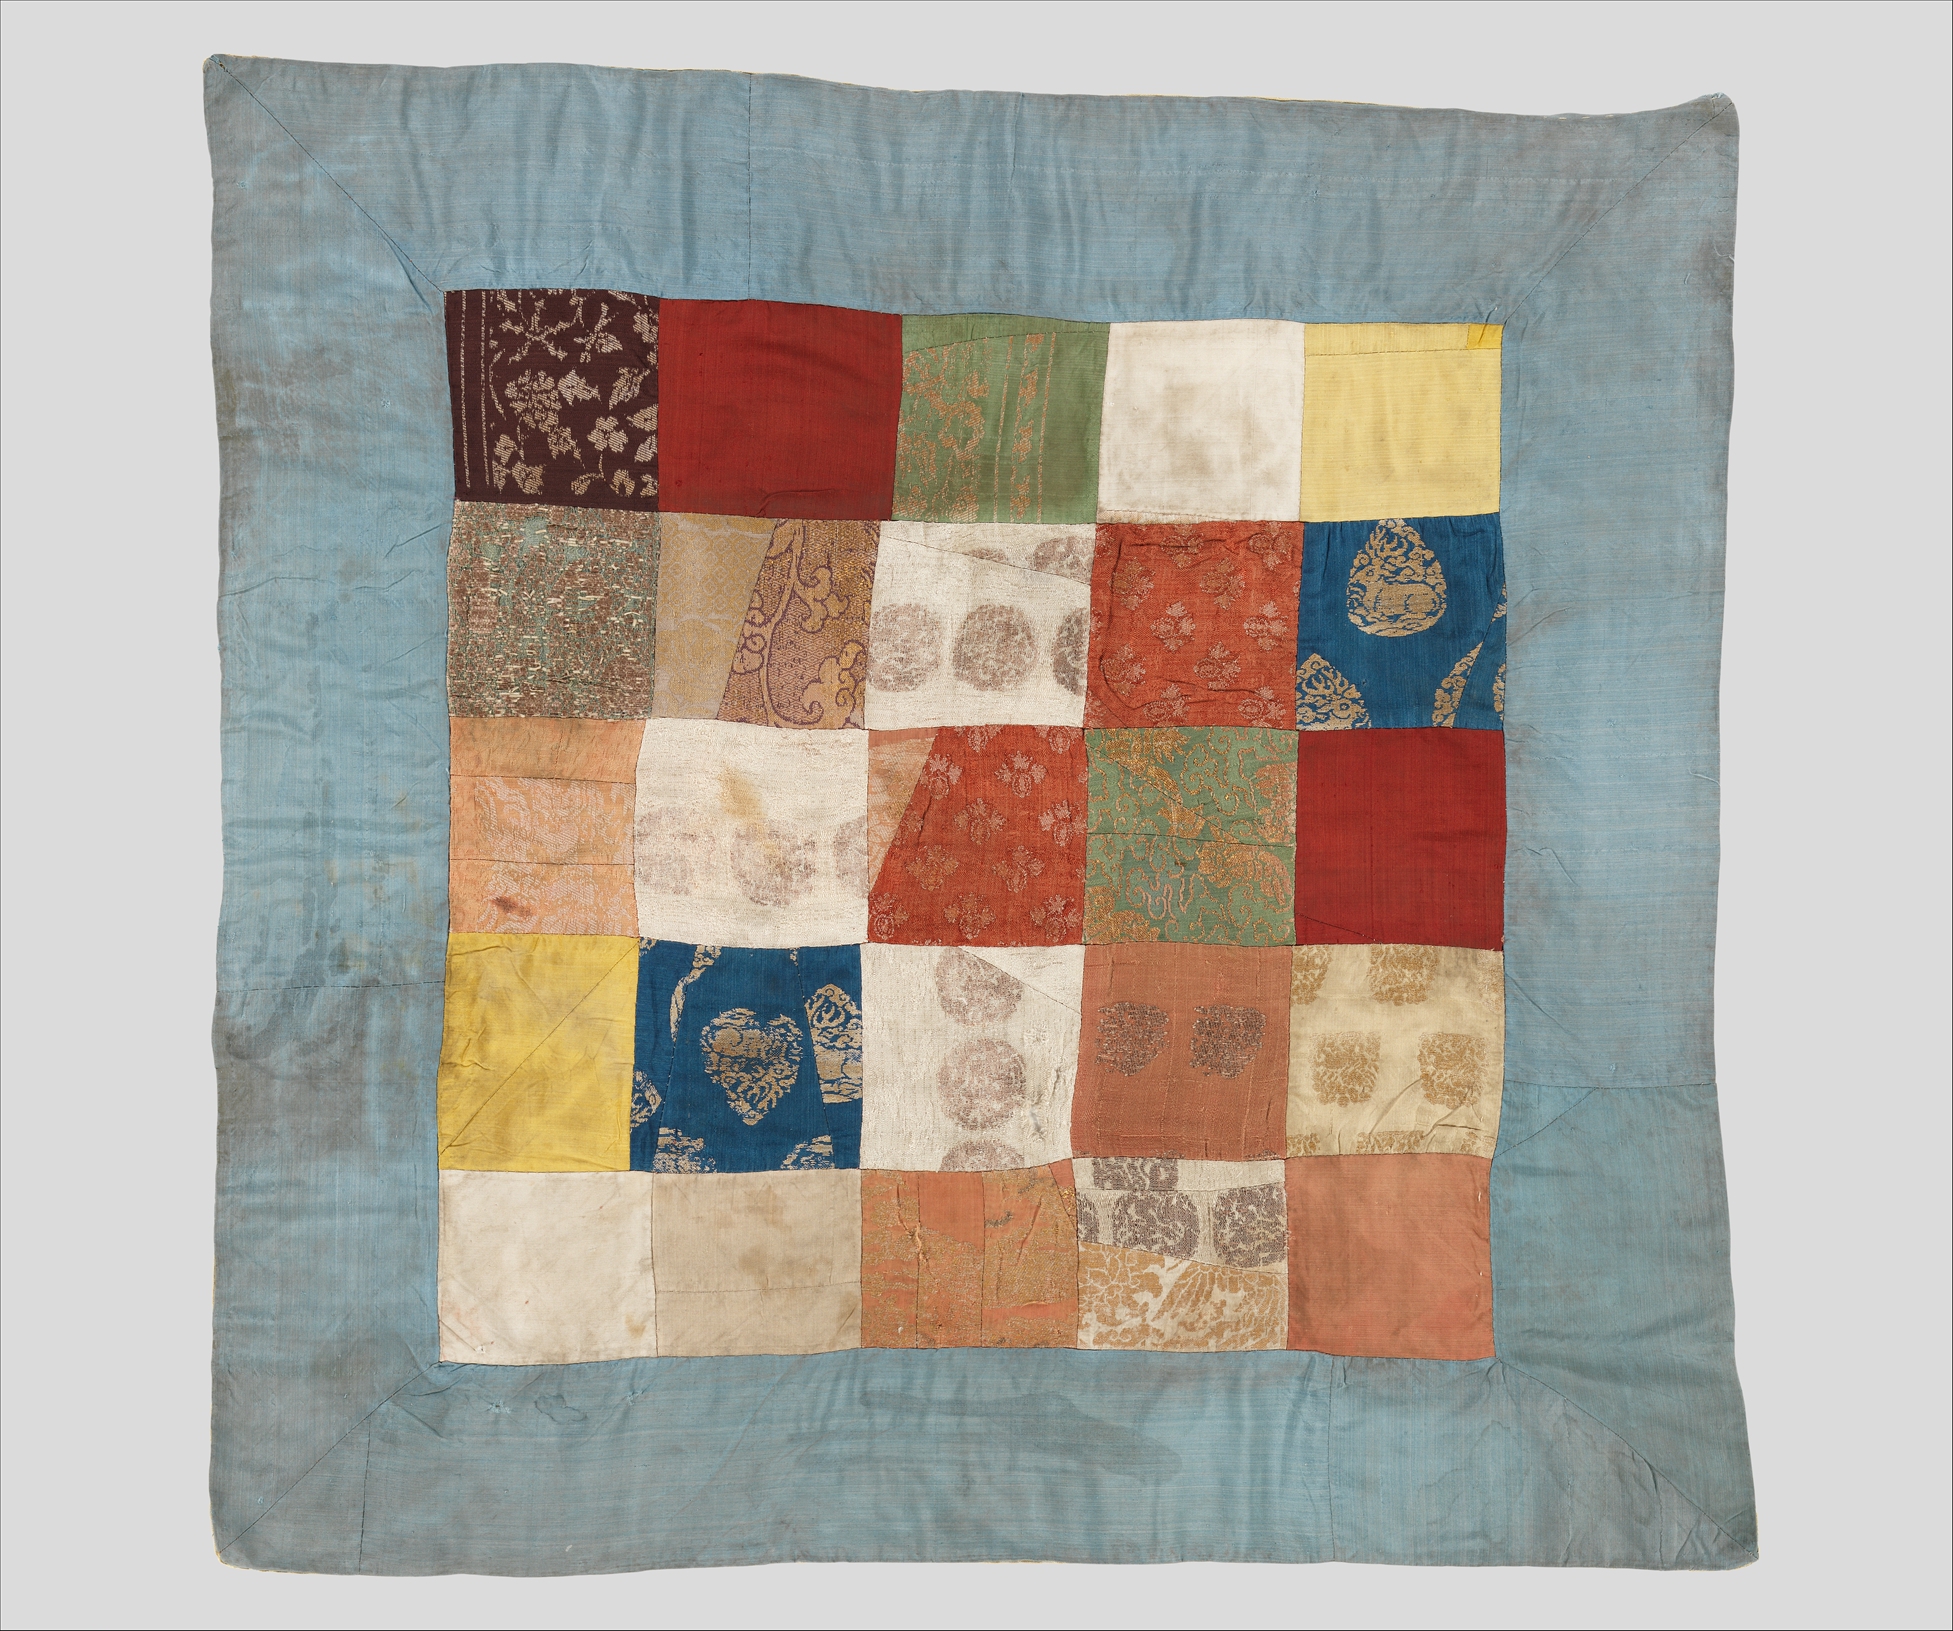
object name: patchwork piece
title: Patchwork of Woven Textiles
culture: chinese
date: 1201-1400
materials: metal thread, silk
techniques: brocade, weave